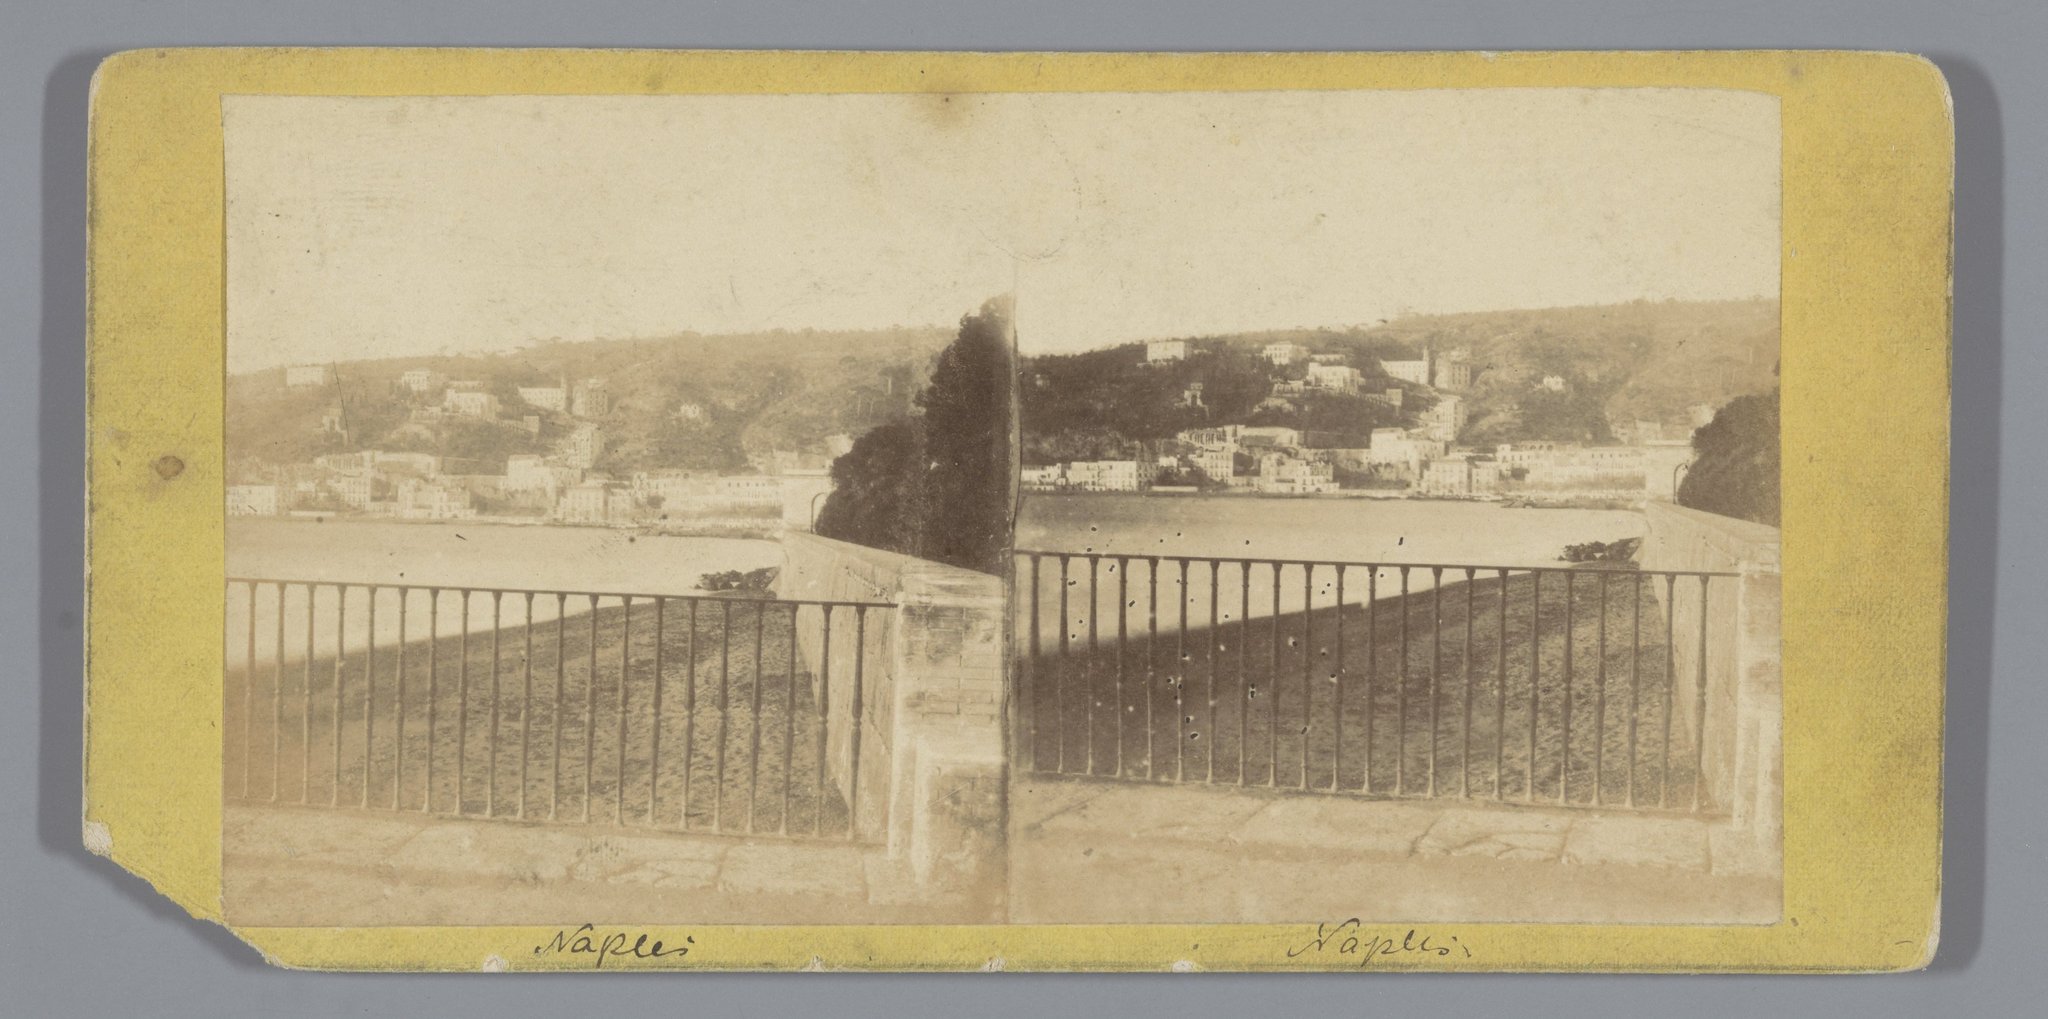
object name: stereograph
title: Gezicht op Napels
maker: Anonymous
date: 1850-1880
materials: cardboard, photographic support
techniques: albumen print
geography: naples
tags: city-view in general; 'veduta', naples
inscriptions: inscription: ‘Naples’